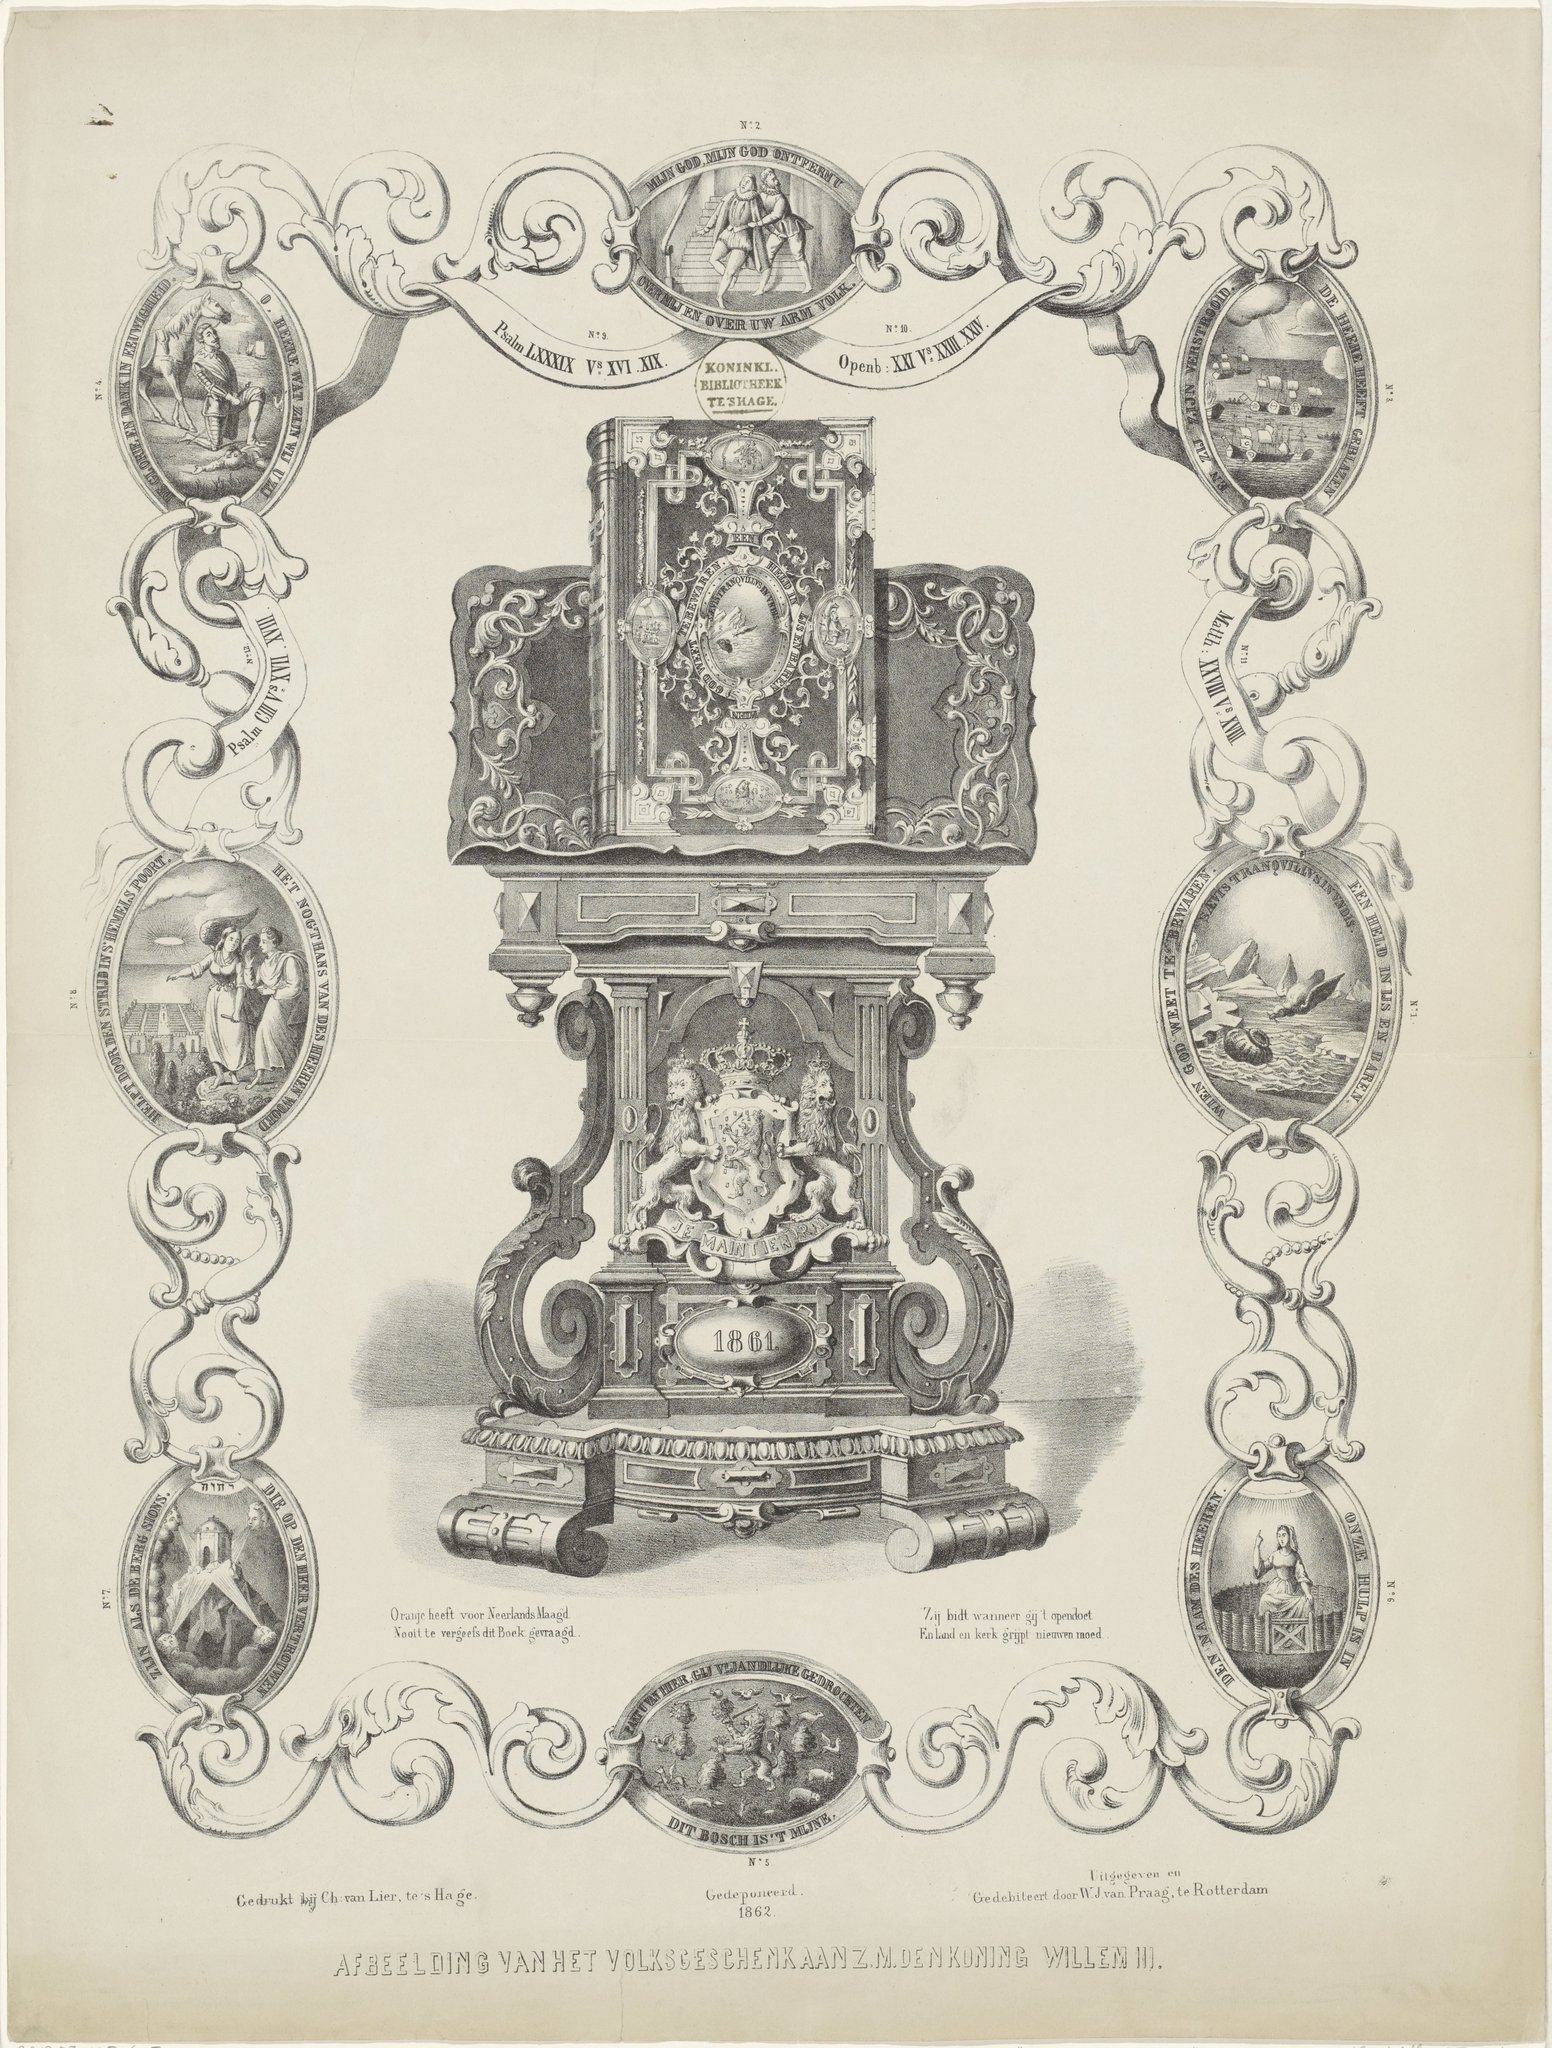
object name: print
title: Volksgeschenk voor Willem III, koning der Nederlanden, aangeboden op 23 maart 1862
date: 1862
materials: paper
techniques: lithograph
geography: rotterdam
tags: brussels, willem iii (koning der nederlanden)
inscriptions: octrooivermelding, gedrukt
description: Volksgeschenk voor Willem III als herinnering aan en als dank voor de deelname van de koning bij de watersnood in 1861, aangeboden op 23 maart 1862. In het midden de prachtbijbel en de lessenaar met zijn wapen en het jaartal '1861'. In de ondermarge twee kolommen met elk twee regels Nederlandse tekst. Geheel in een geornamenteerde rechthoek met acht voorstellingen, elk in een ovaal met randschrift.